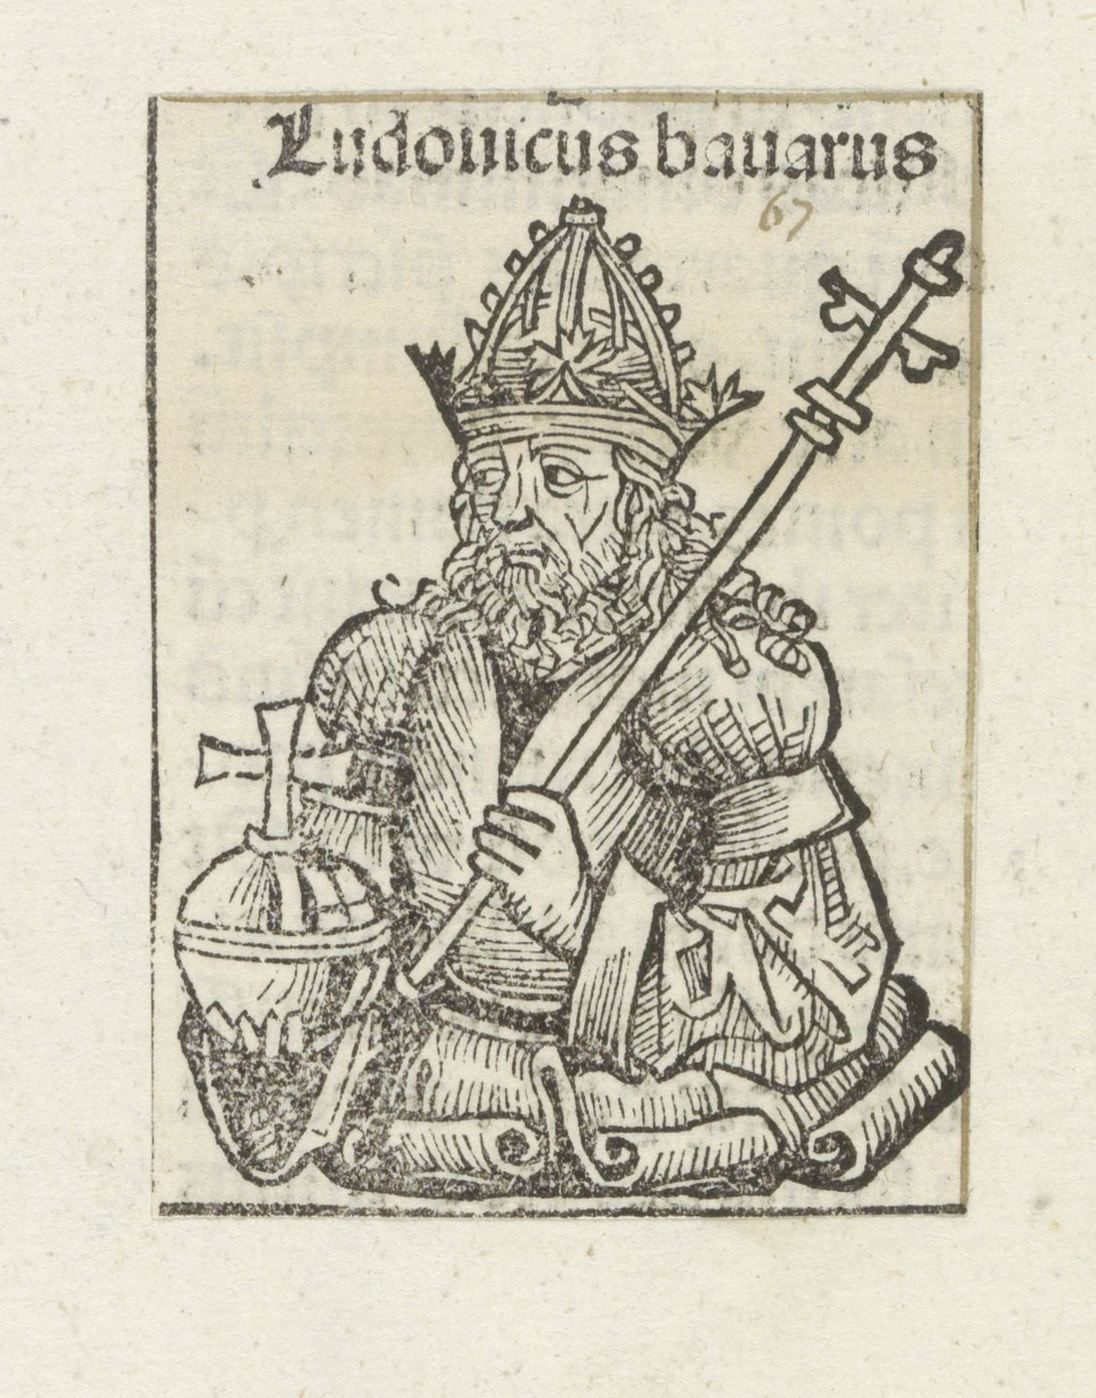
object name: album leaf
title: Keizer Lodewijk de Beier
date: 1493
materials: paper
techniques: letterpress printing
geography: nuremberg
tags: emperor, king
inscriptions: inscription: ‘67’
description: Een bloemkelk met een koning, naar links gekeerd. In zijn handen heeft hij een rijksappel en een scepter. De voorstelling is onderdeel van de opeenvolging keizers in de Liber Chronicarum. De tekst identificeert de man als keizer Lodewijk de Beier. De prent maakt deel uit van een album.